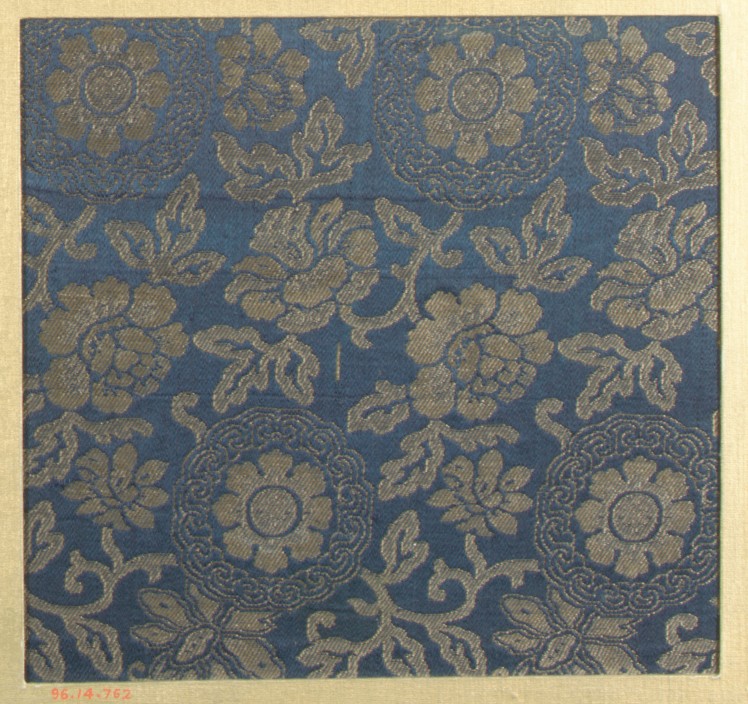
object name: piece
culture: japanese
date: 1701-1900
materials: silk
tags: leaves